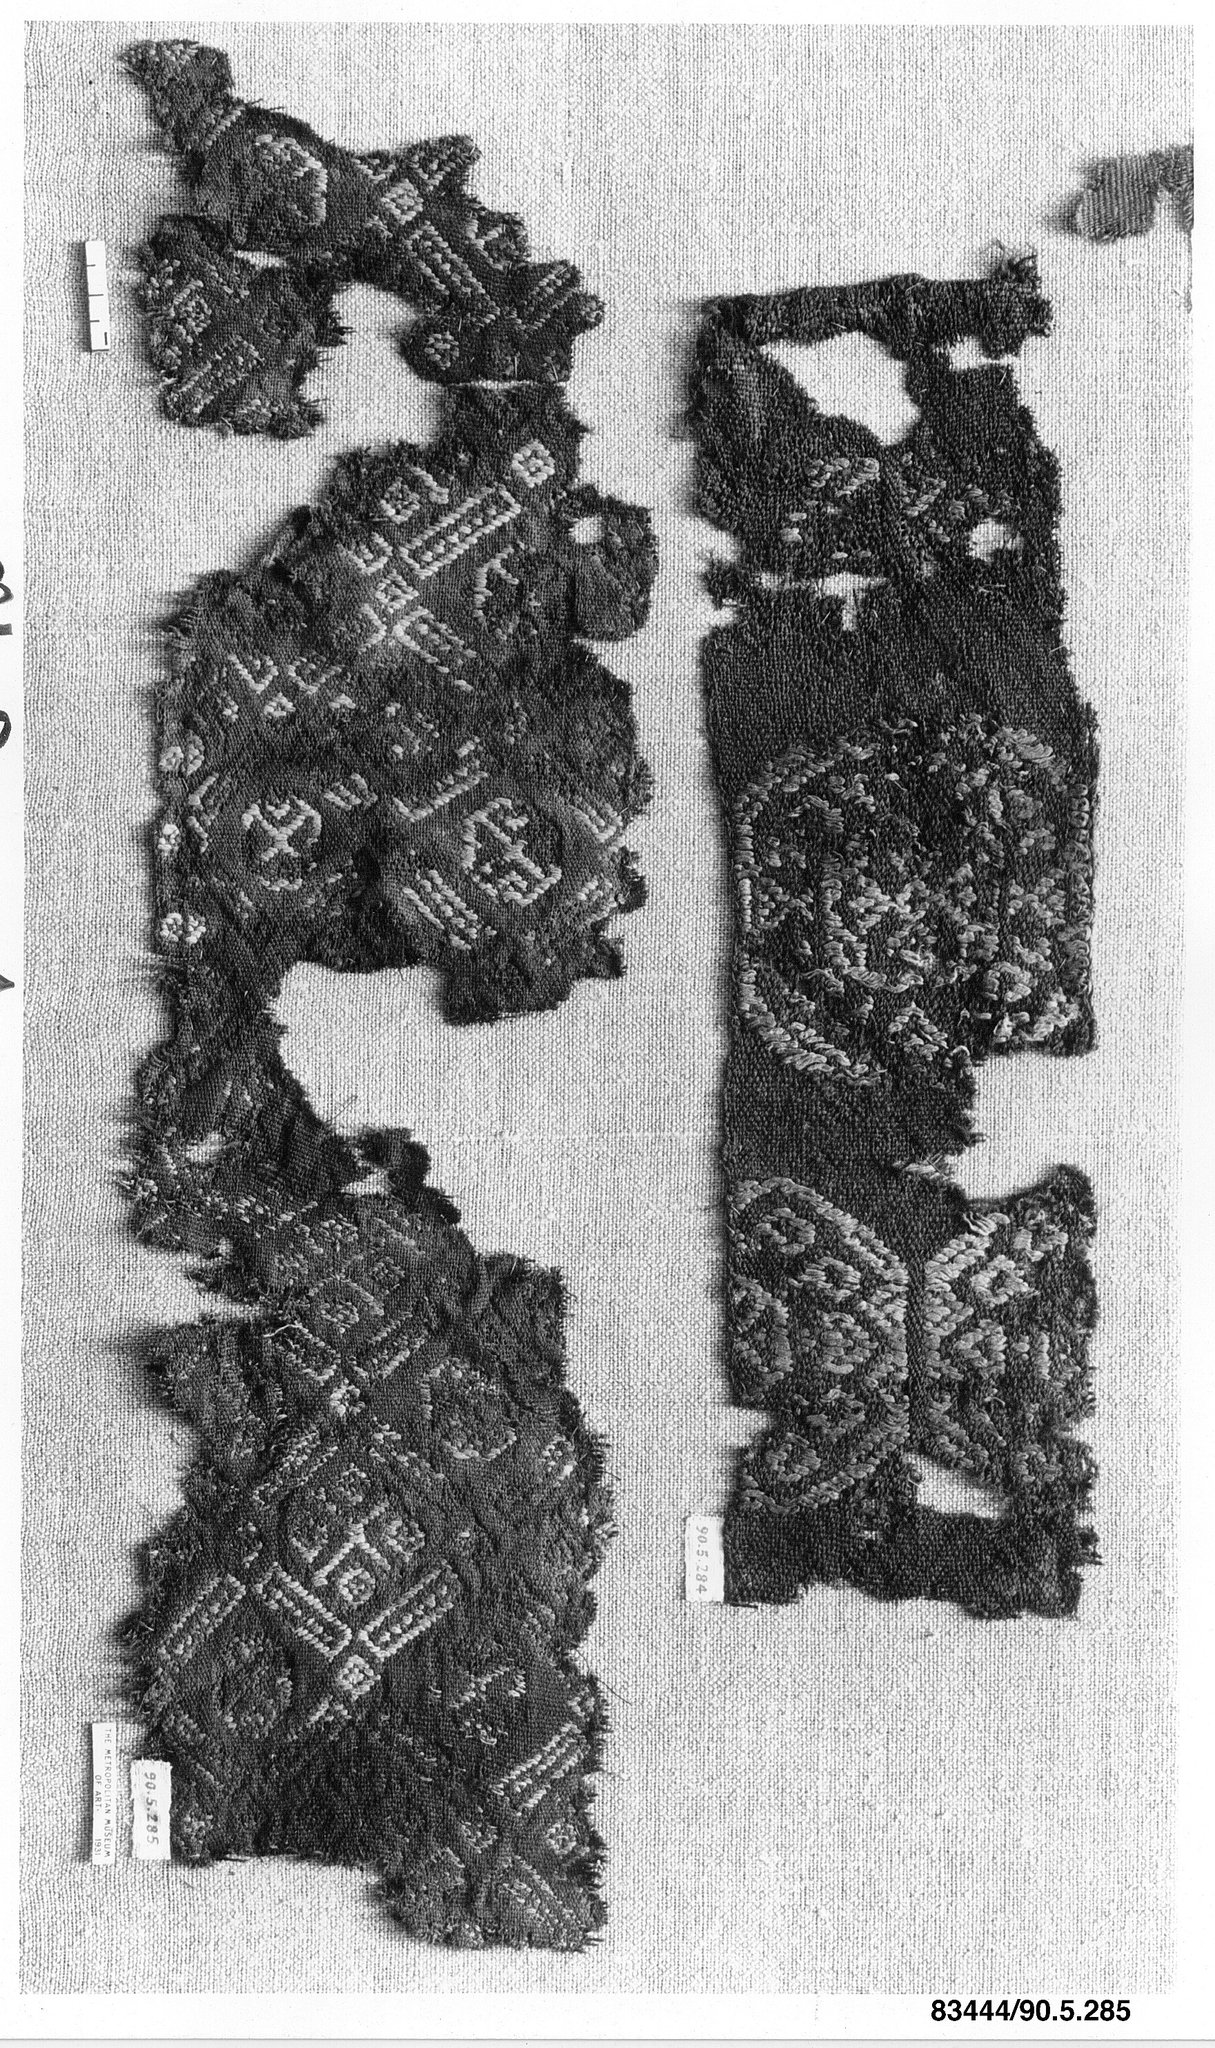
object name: textile fragment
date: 401-600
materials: linen, wool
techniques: weave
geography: egypt